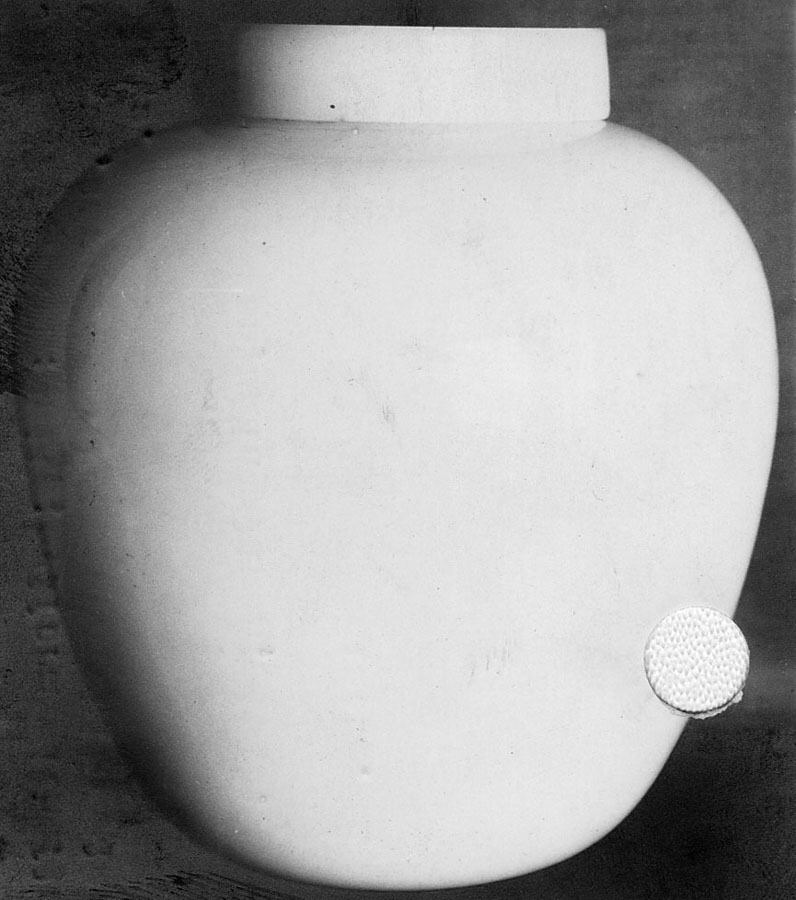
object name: jar with cover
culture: chinese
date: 1736-1795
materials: glass